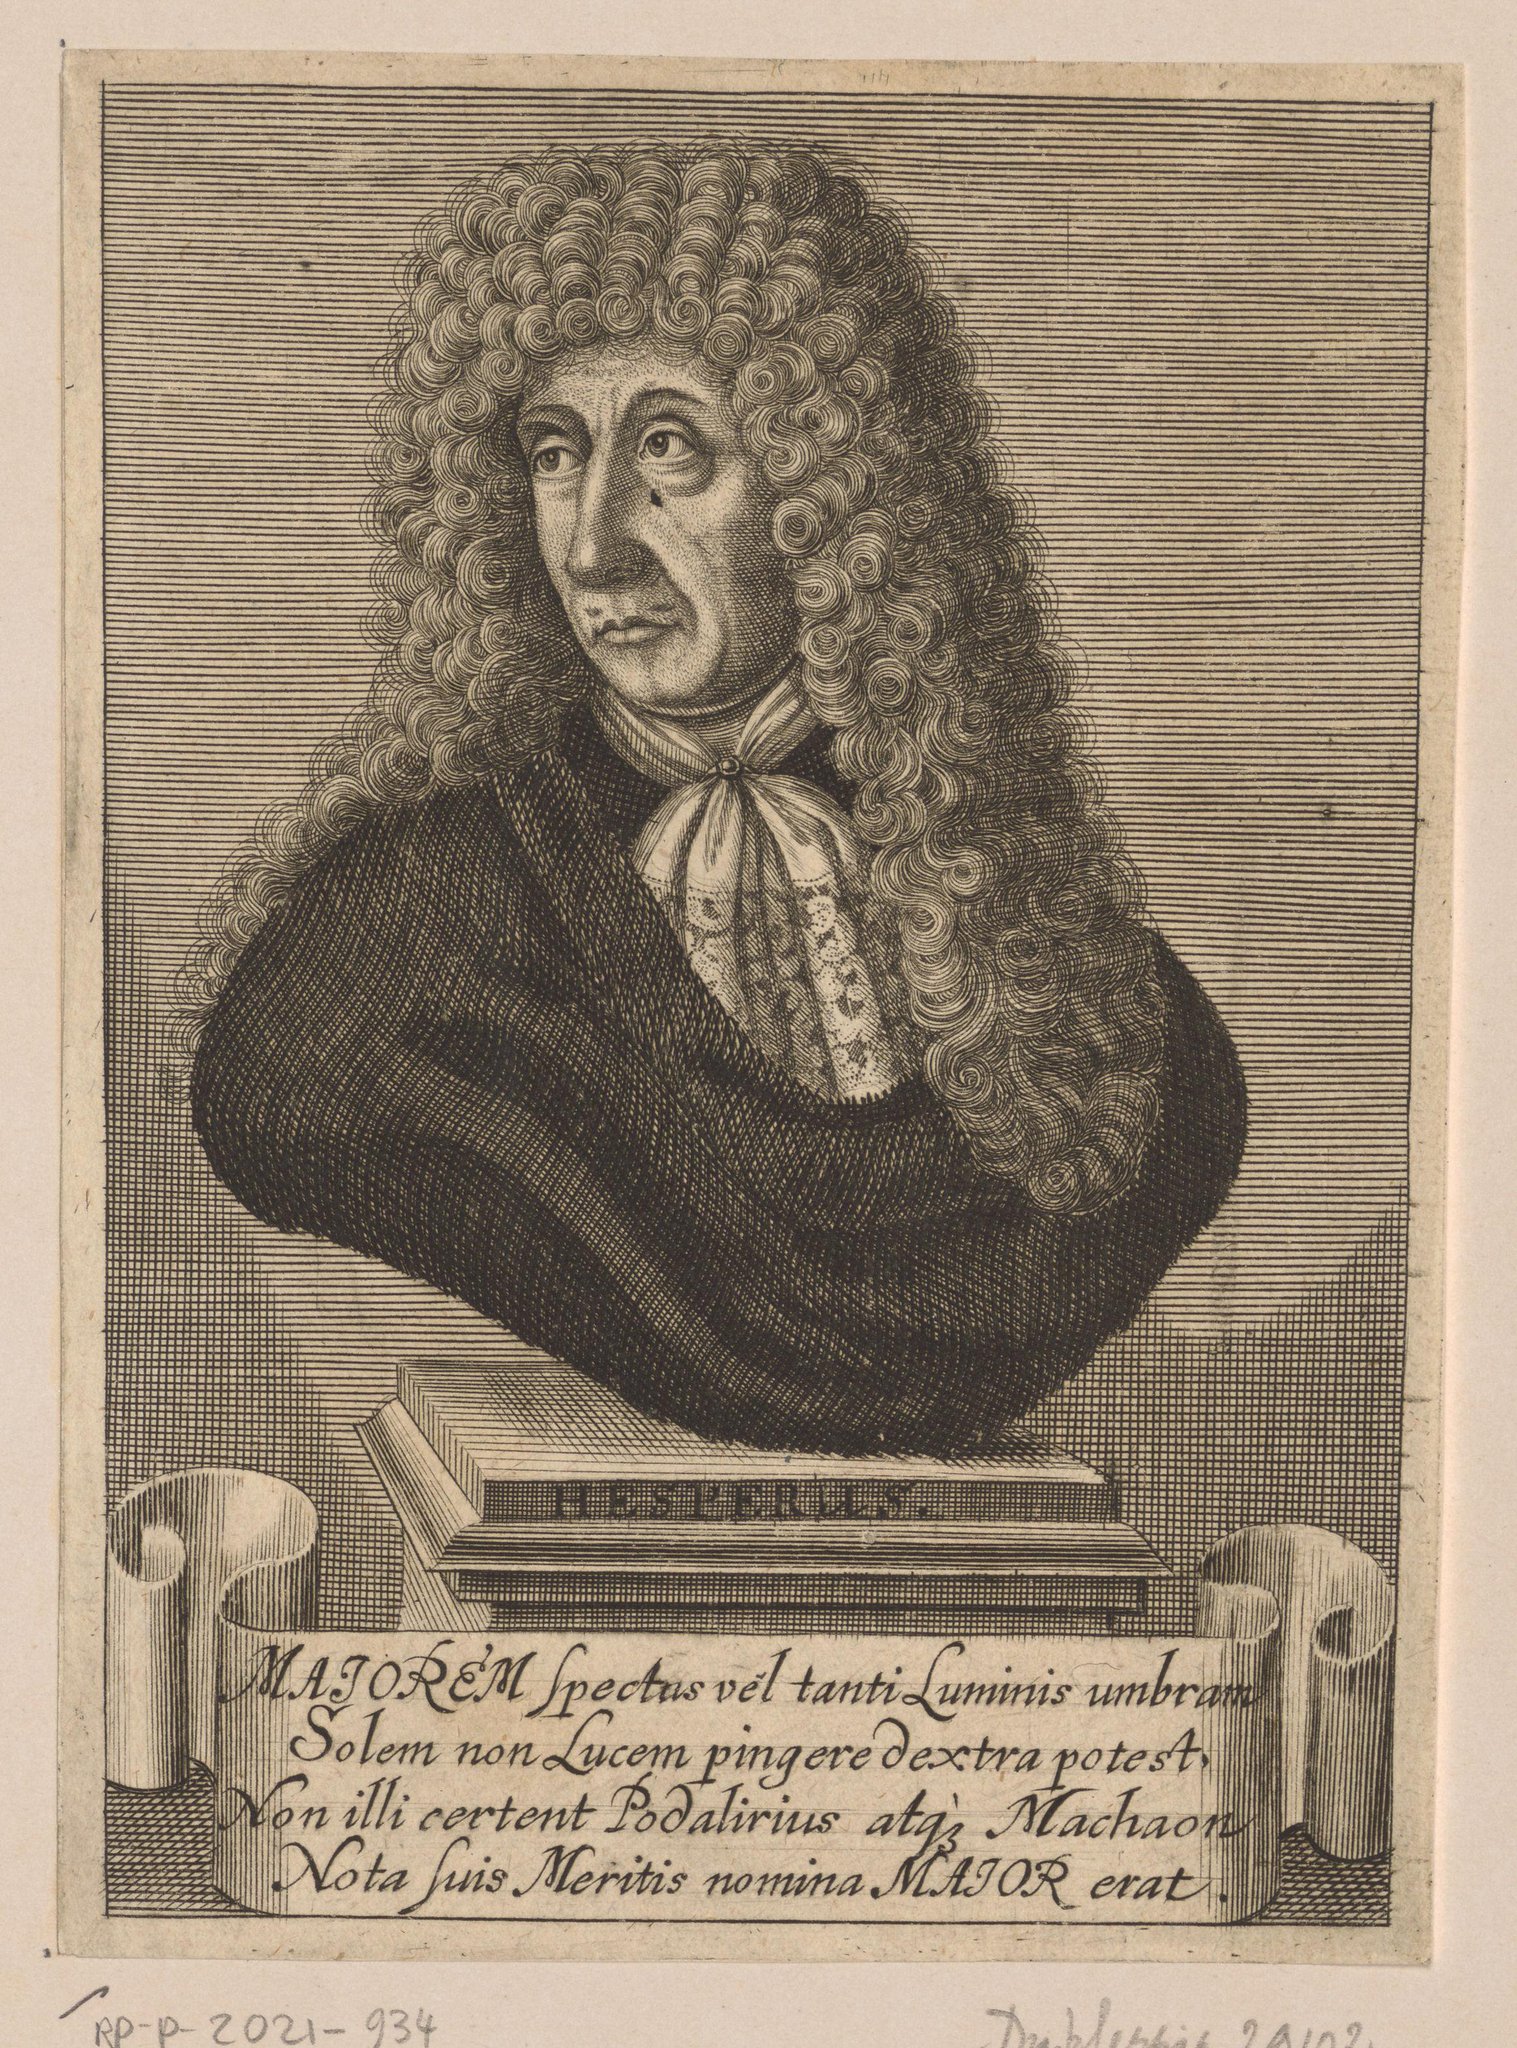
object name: print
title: Portret van Johann Daniel Major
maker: Anonymous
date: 1644-1693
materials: paper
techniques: engraving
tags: botany (+ portrait of scholar, scientist), historical persons